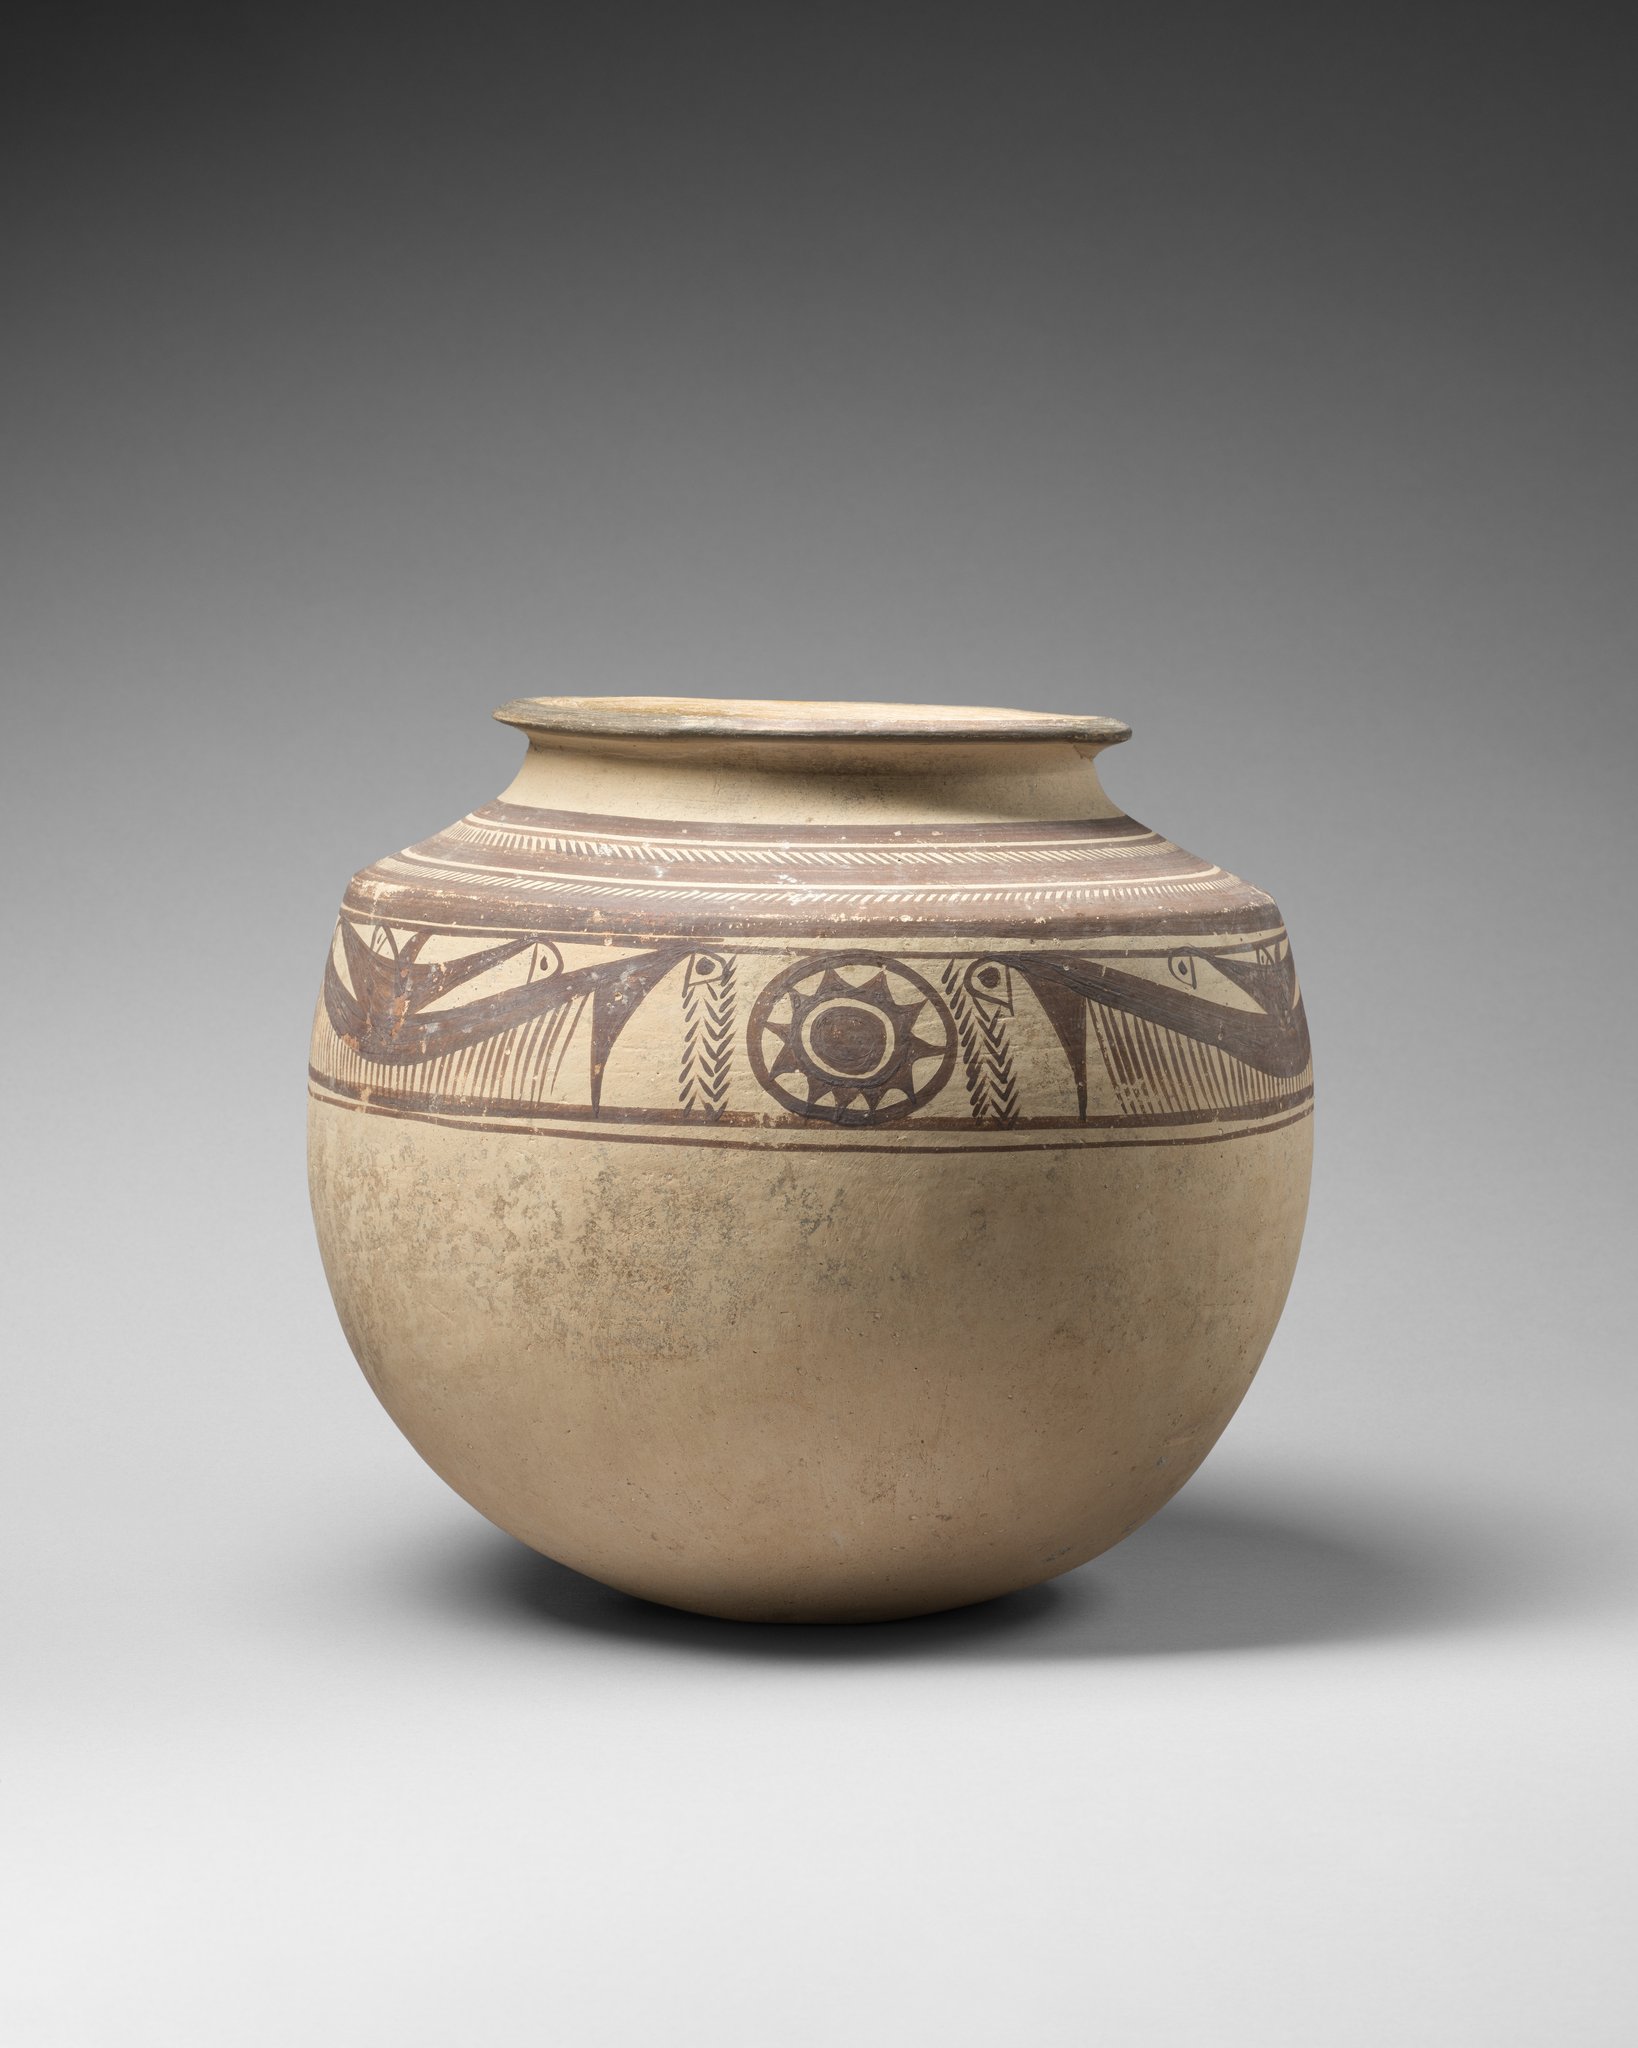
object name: jar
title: Jar with a frieze of stylized animals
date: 2500-1900 BCE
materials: ceramic, paint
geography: western iran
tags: animals